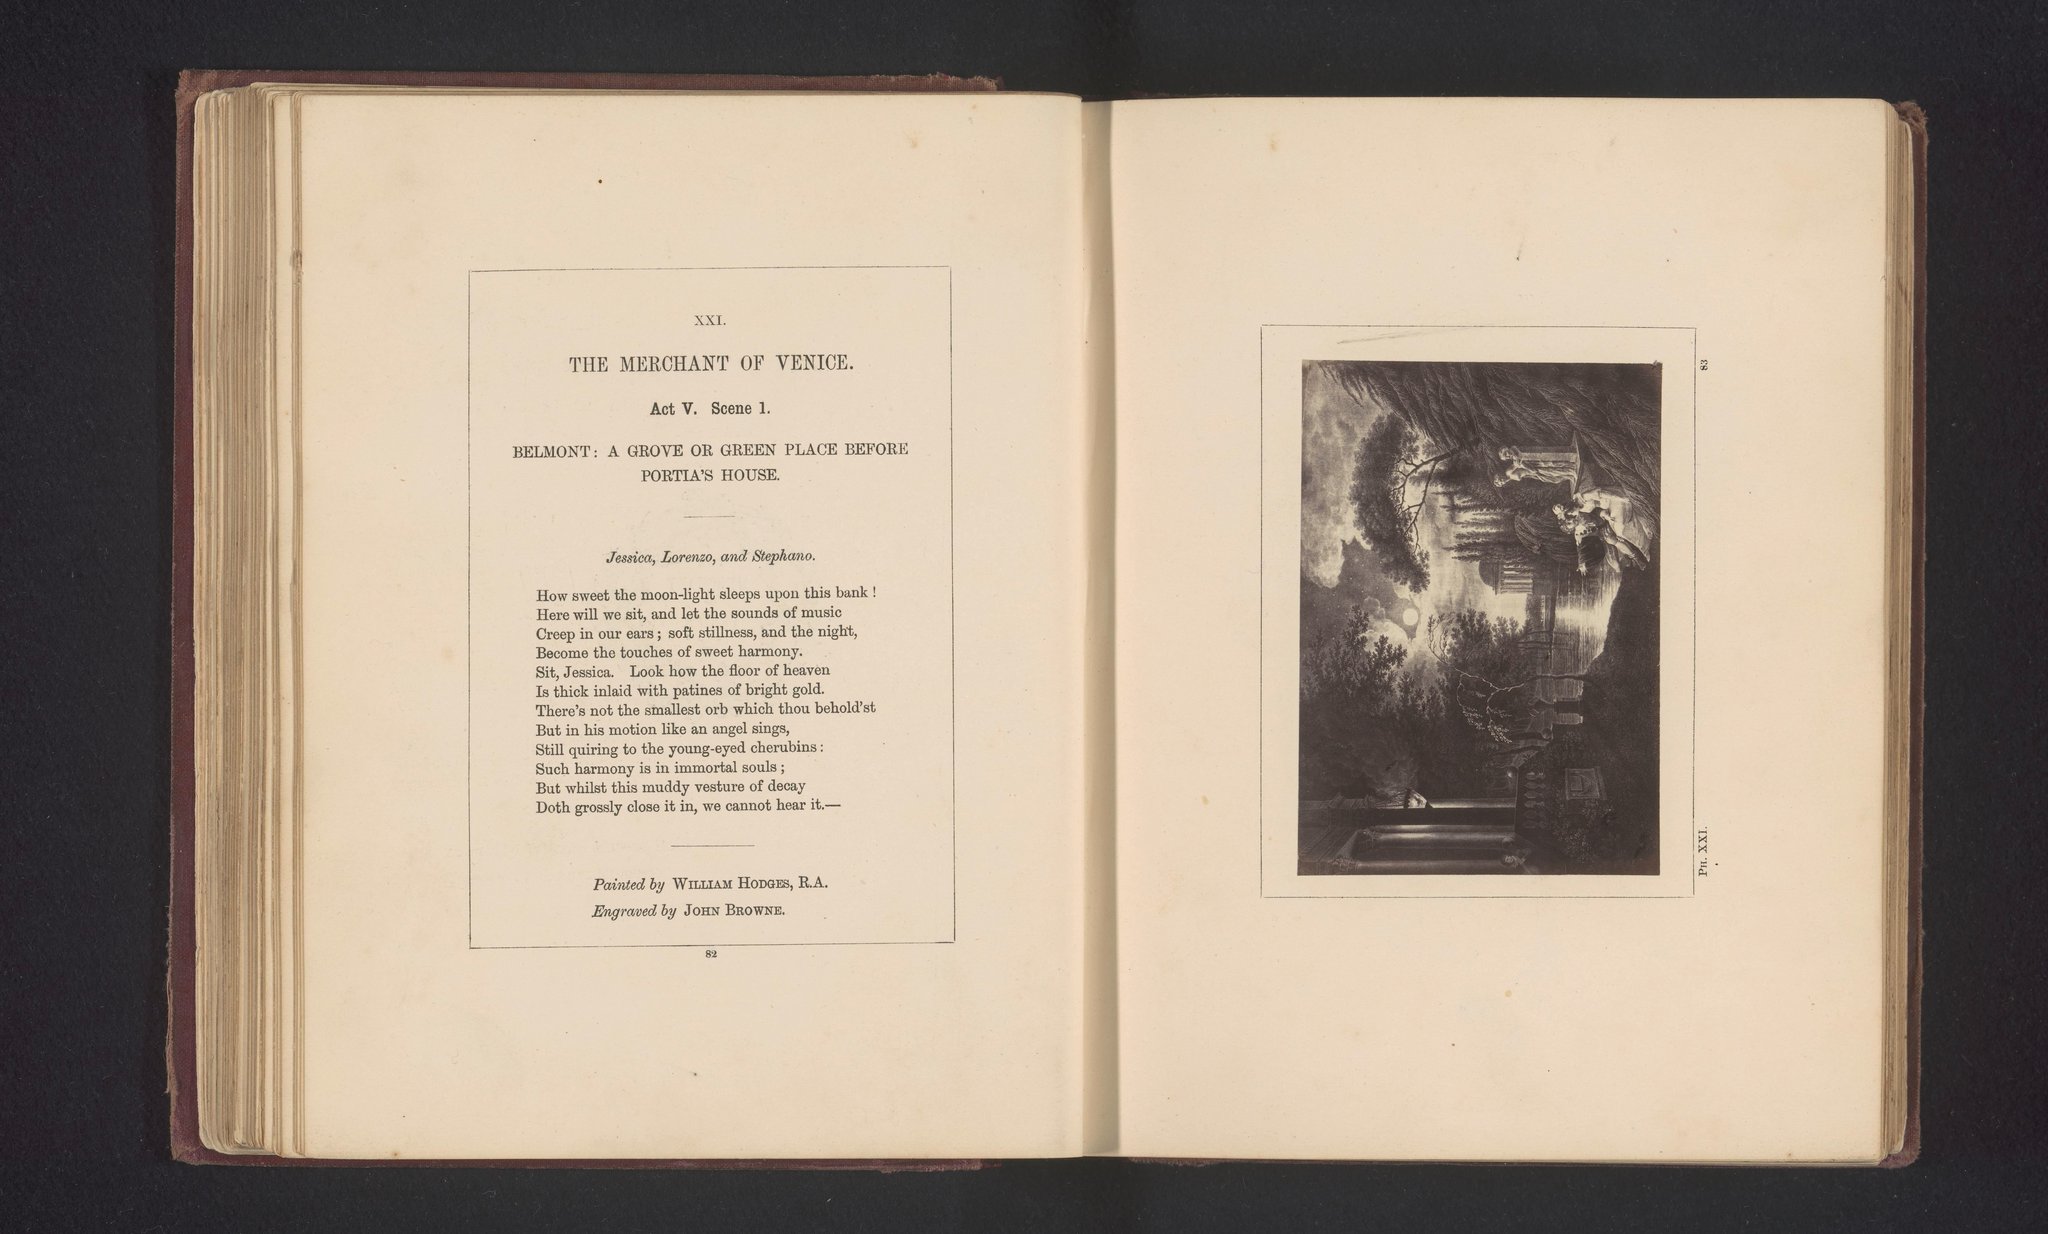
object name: photograph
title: Fotoreproductie van een prent naar een schilderij door William Hodges, voorstellend een scene uit De koopman van Venetië door William Shakespeare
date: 1854-1867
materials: photographic support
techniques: albumen print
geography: london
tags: specific works of literature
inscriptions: number: ‘Ph. XXI. 83’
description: Te zien is akte V, scene 1 met Jessica en Lorenzo op een bankje en Stephano die toekijkt.